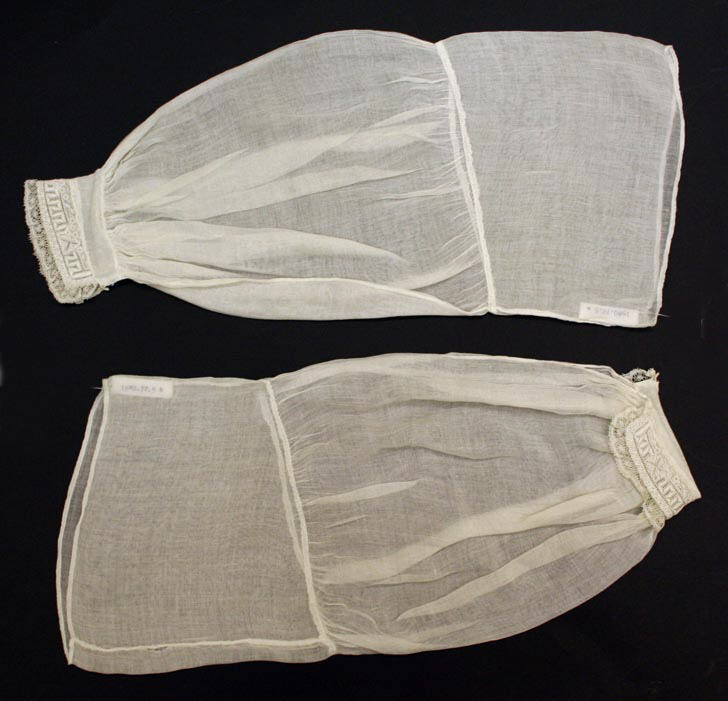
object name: undersleeves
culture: american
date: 1860-1869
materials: cotton